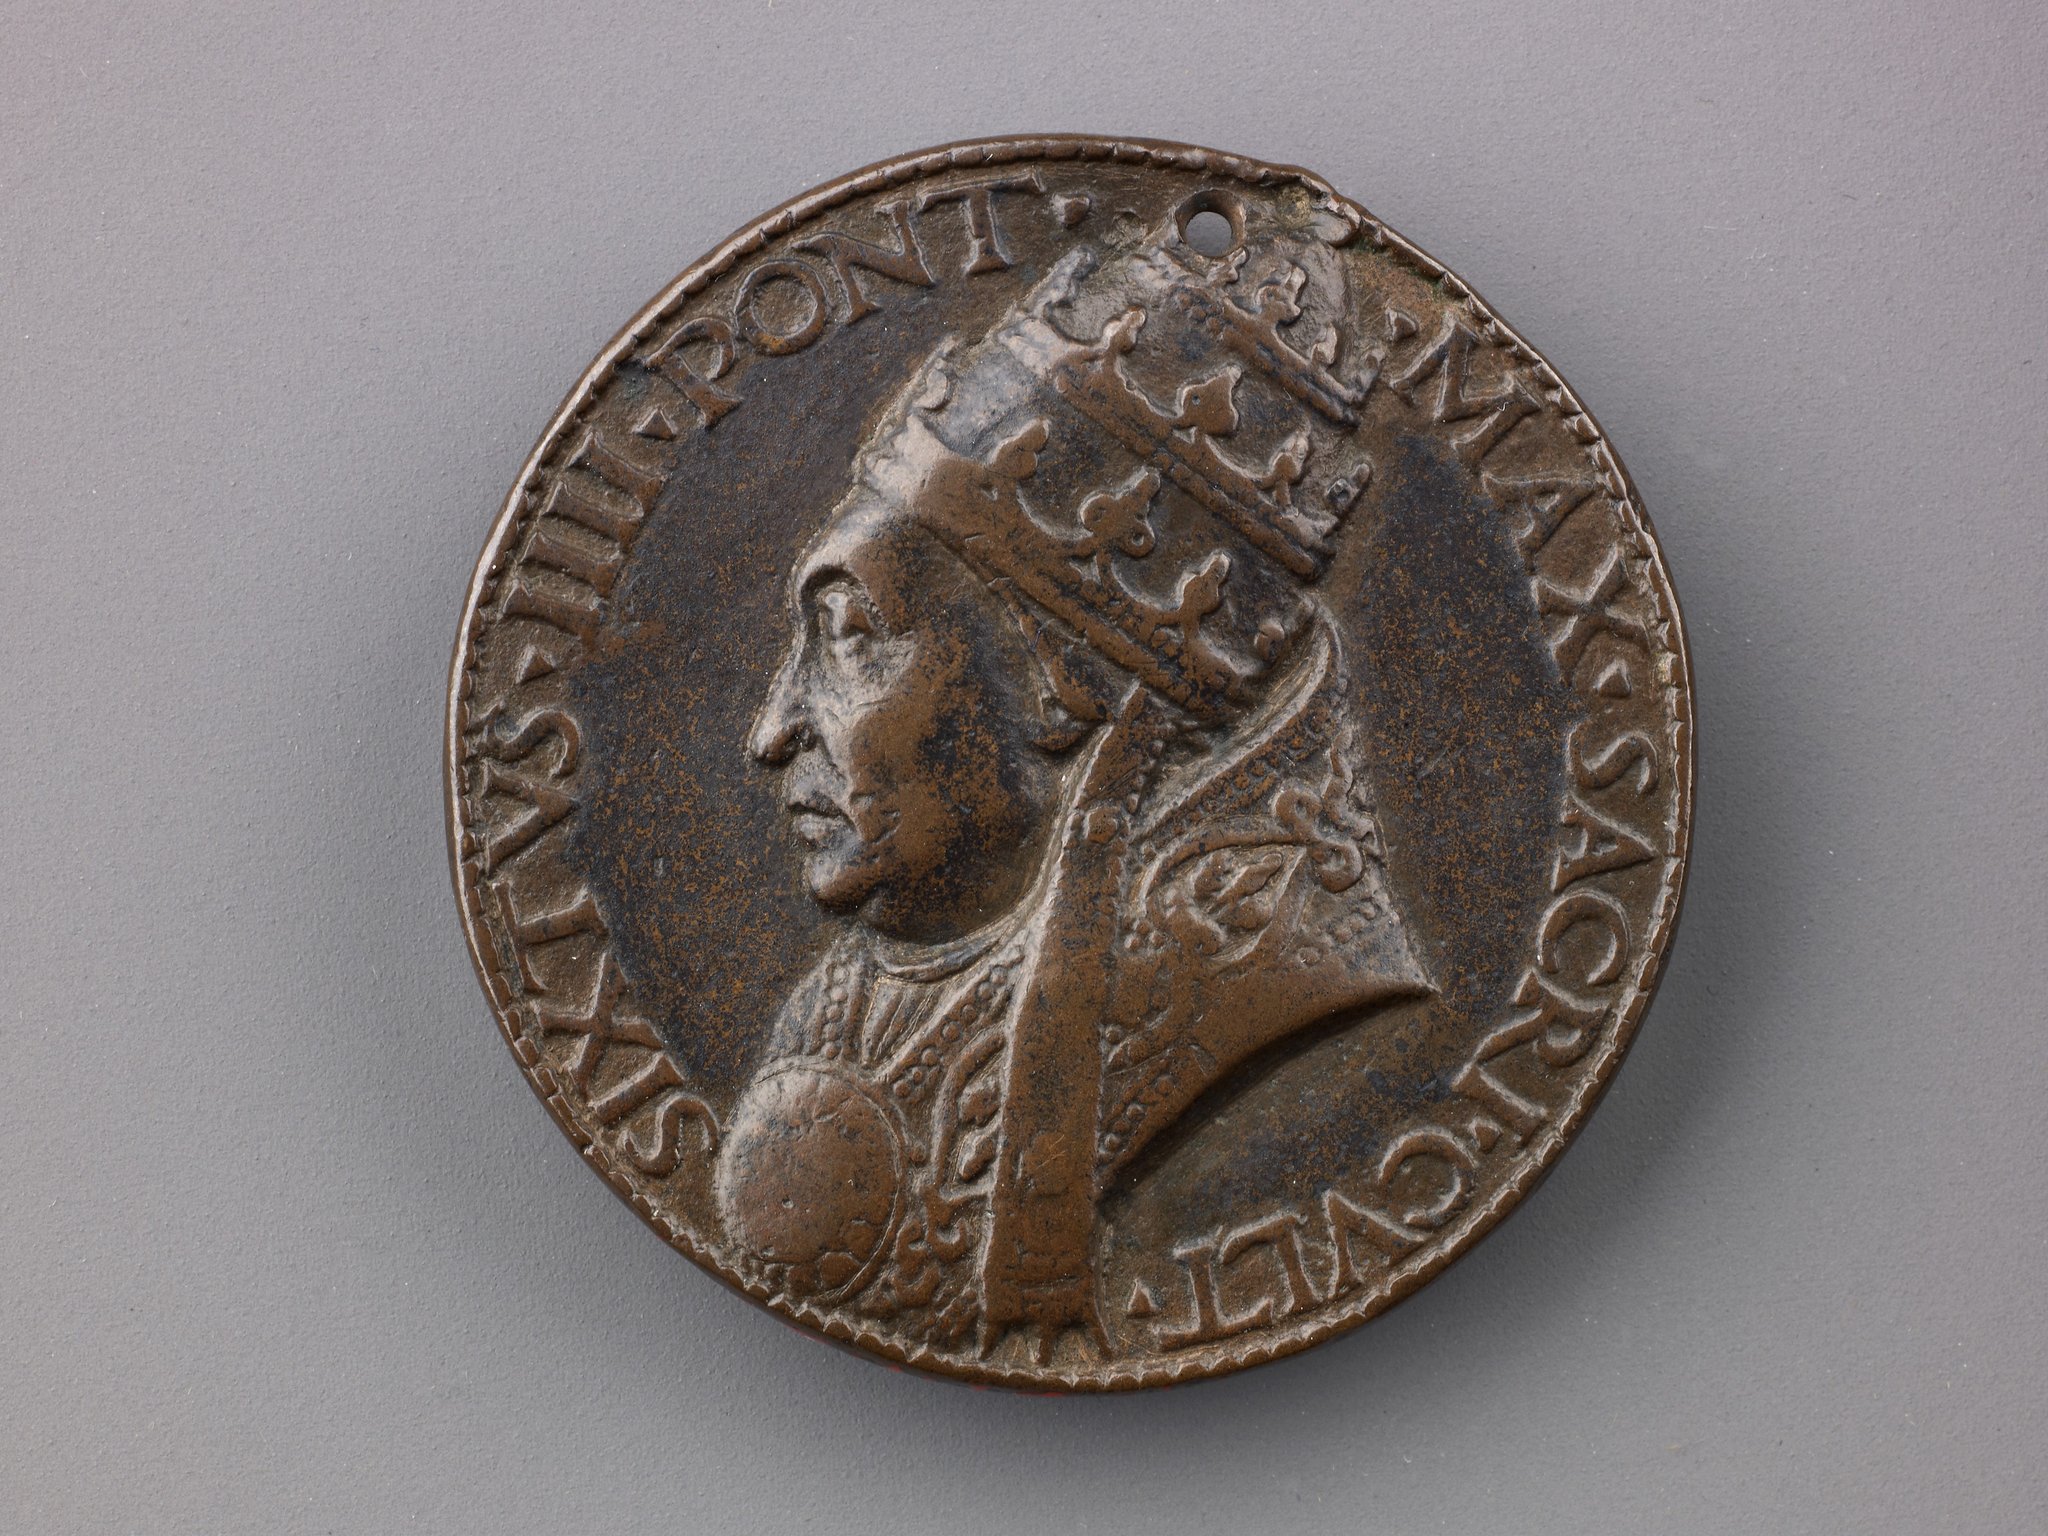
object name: medal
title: Medal: Sixtus IV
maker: lysippus the younger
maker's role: artist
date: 1471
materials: bronze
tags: men,portraits